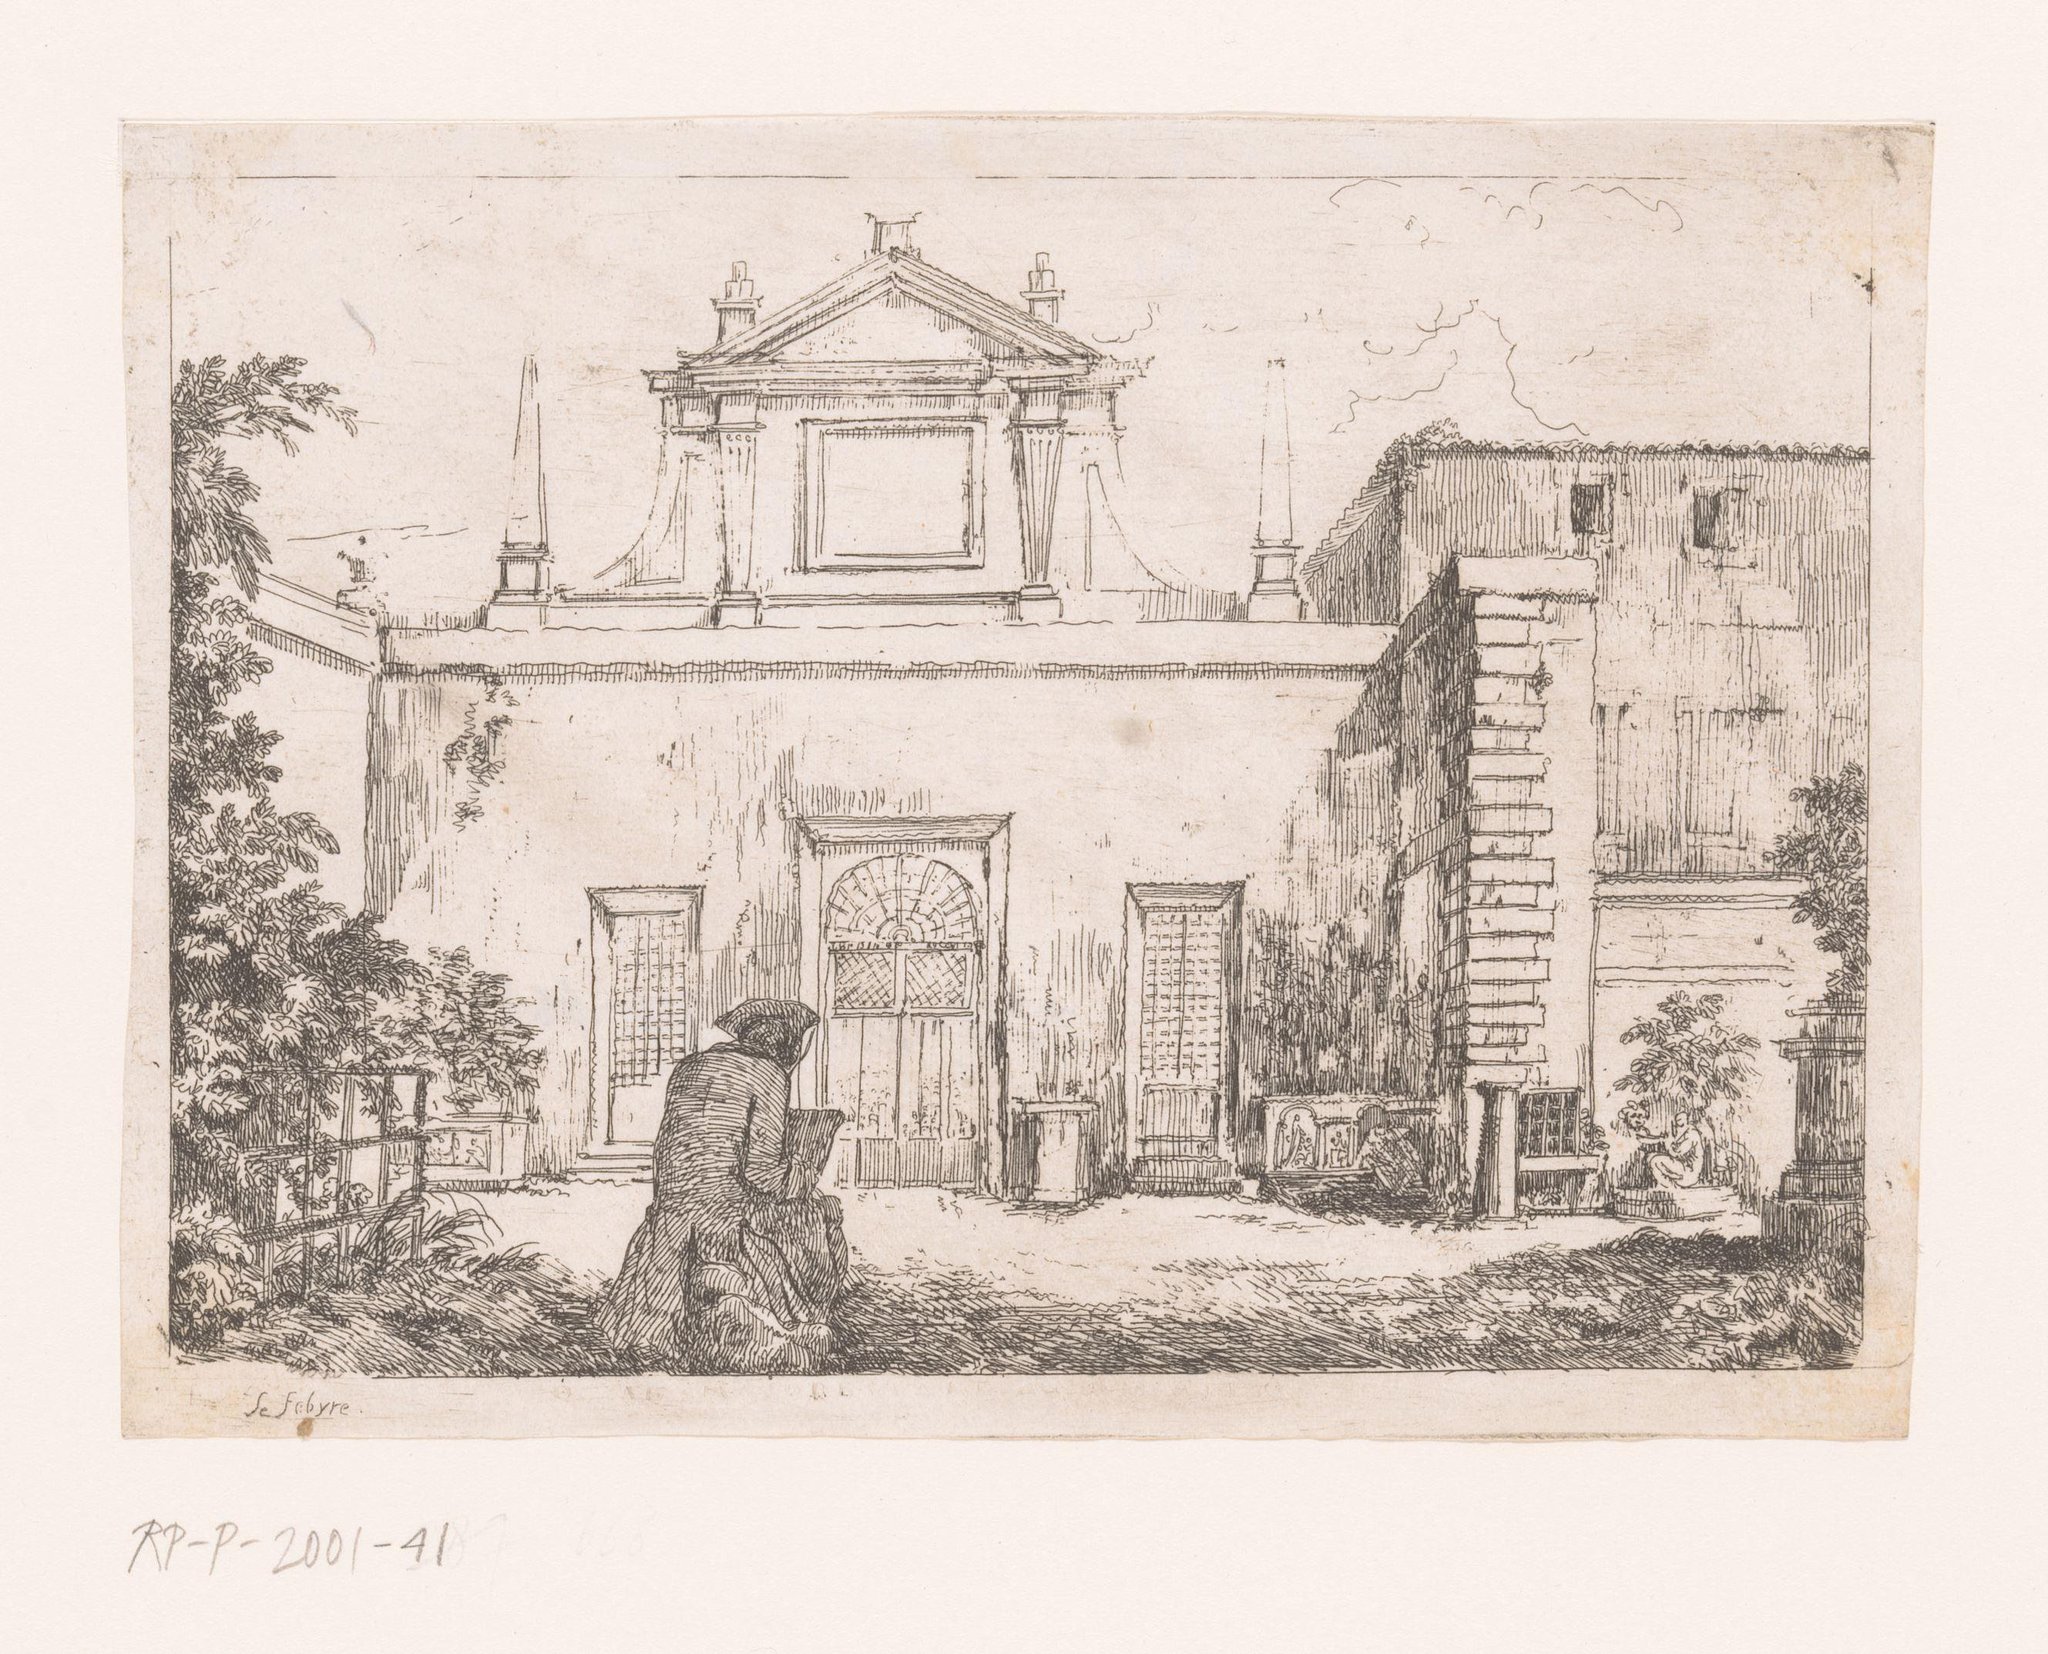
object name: print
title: Tekenaar op een binnenplaats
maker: claude lefèbvre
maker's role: painter, print maker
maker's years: 1632-1675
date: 1600-1699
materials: paper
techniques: etching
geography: france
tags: draughtsman at work - cc - out of doors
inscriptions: collector's mark: Lugt 2228